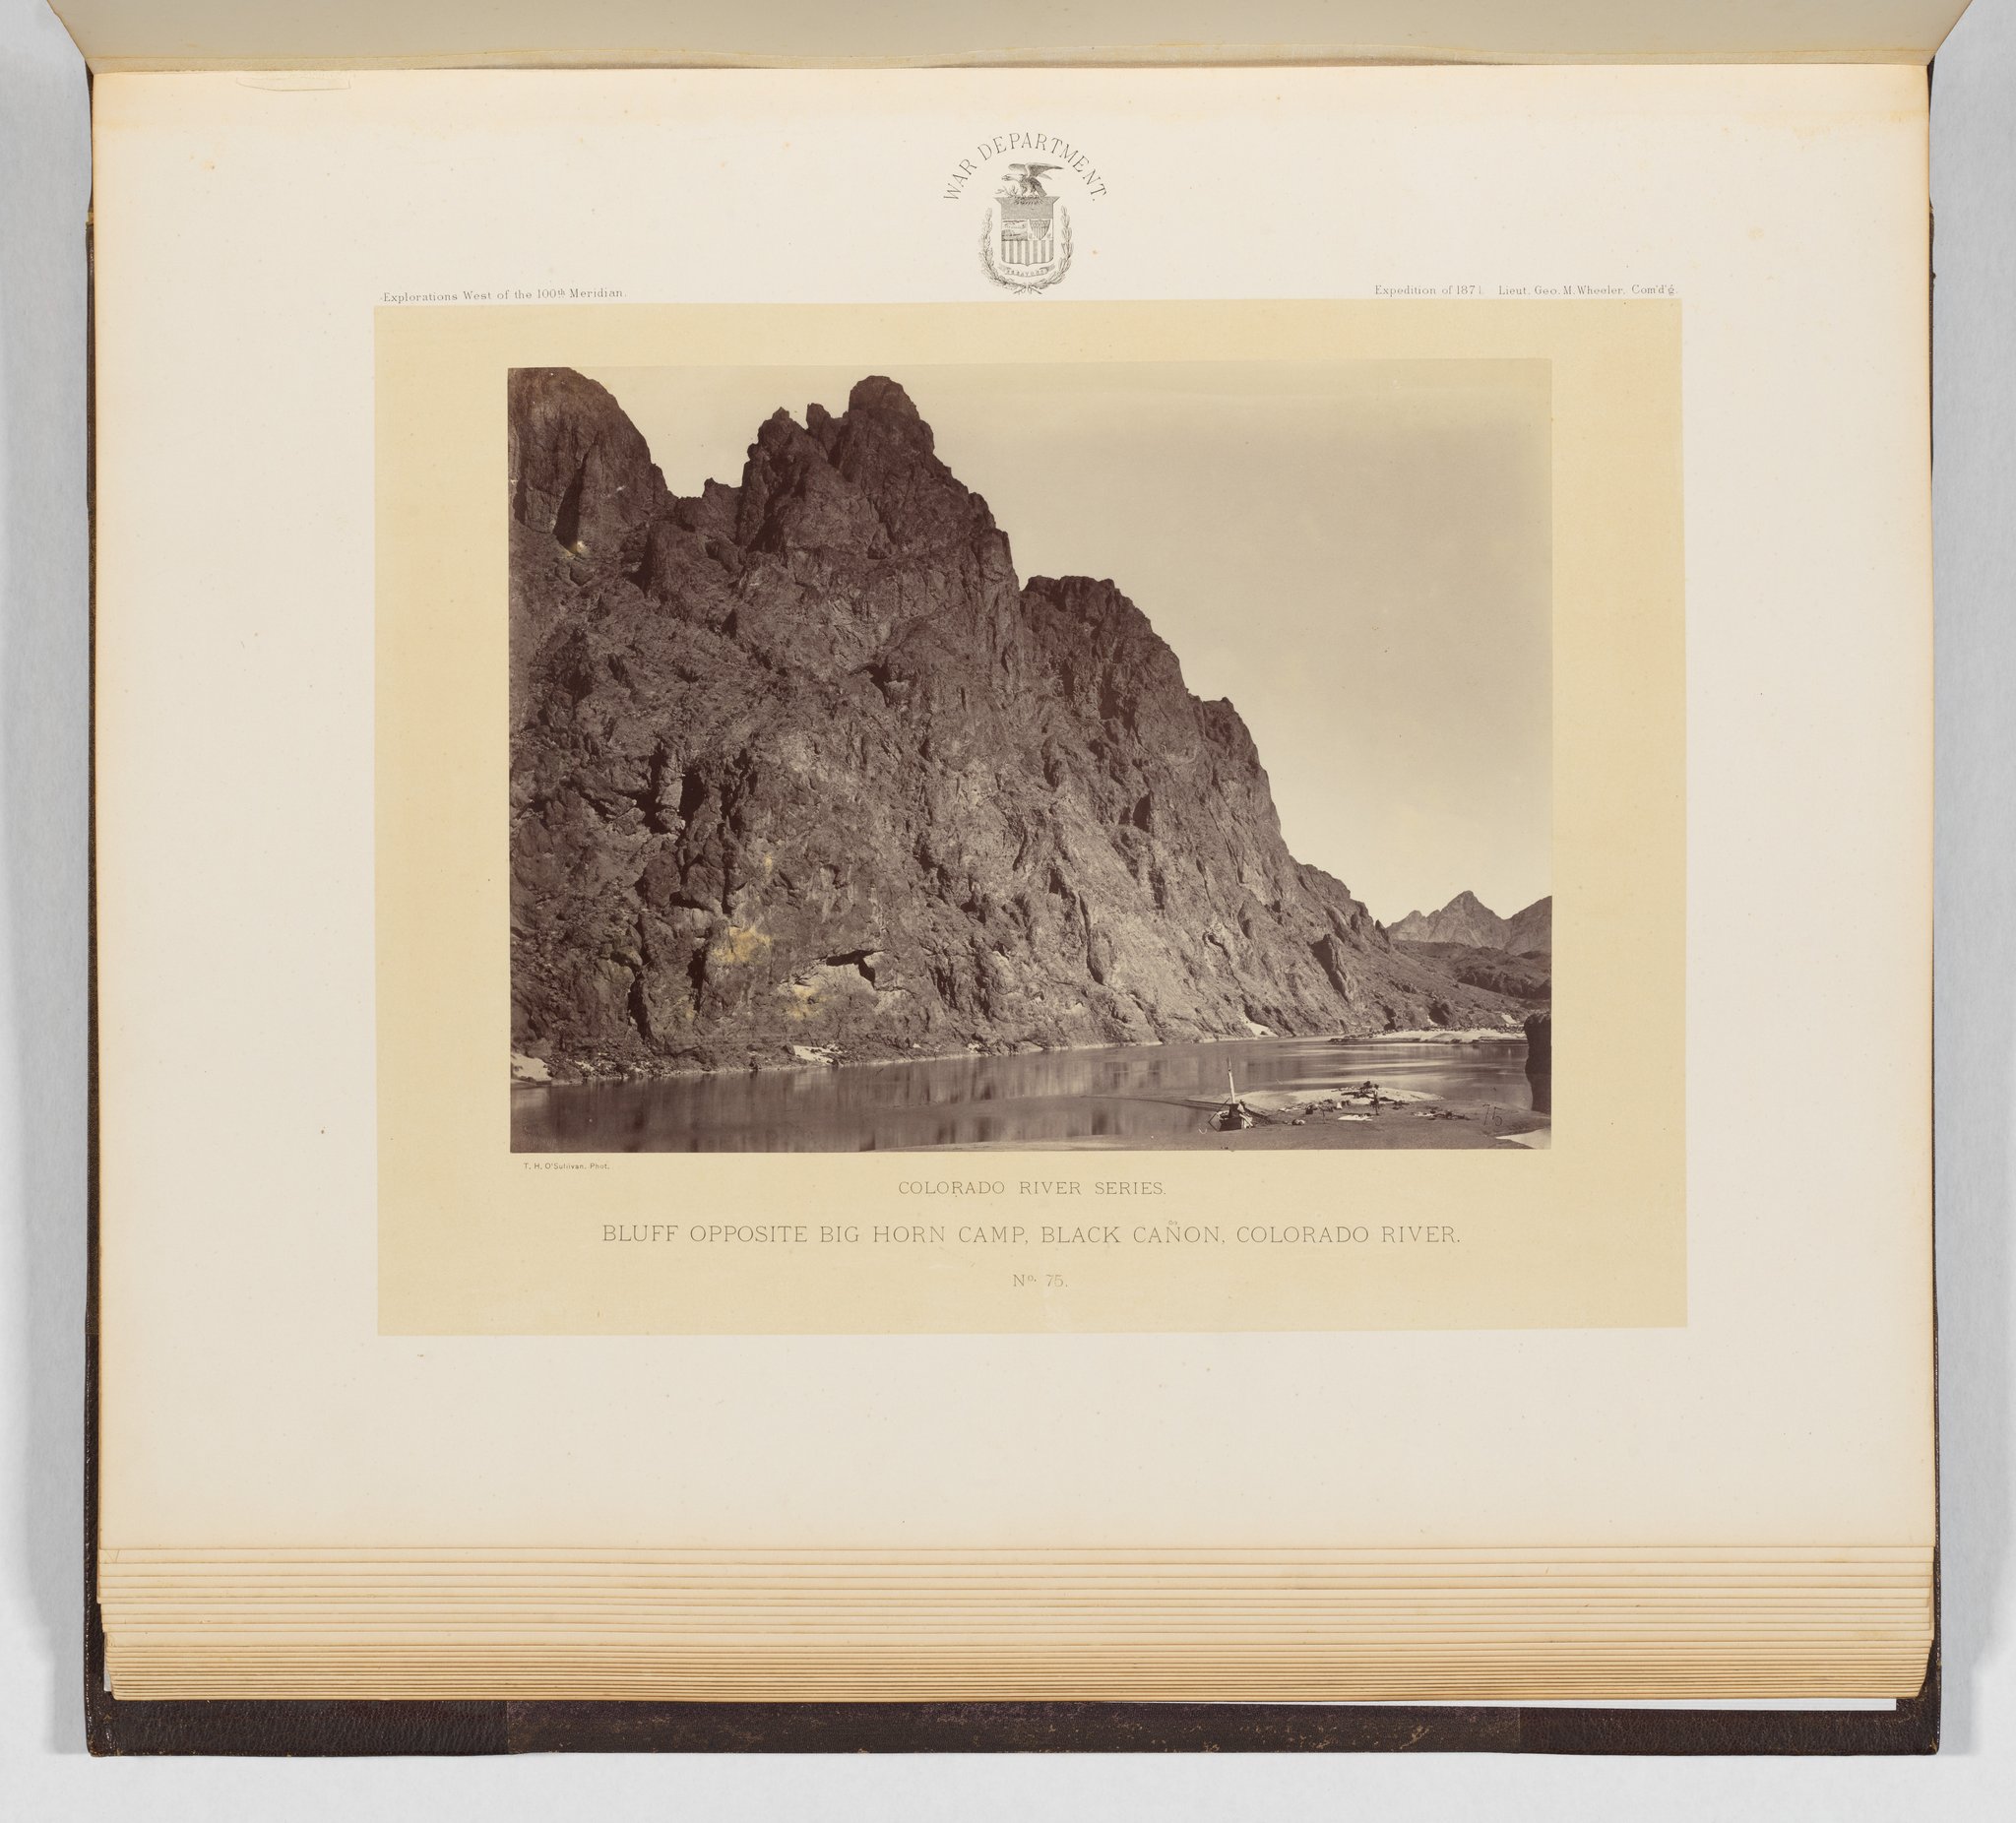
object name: photograph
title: Bluff Opposite Big Horn Camp, Black Cañon, Colorado River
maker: timothy h. o'sullivan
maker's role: artist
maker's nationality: american, born ireland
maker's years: 1840-1882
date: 1871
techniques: albumen silver print, glass negative